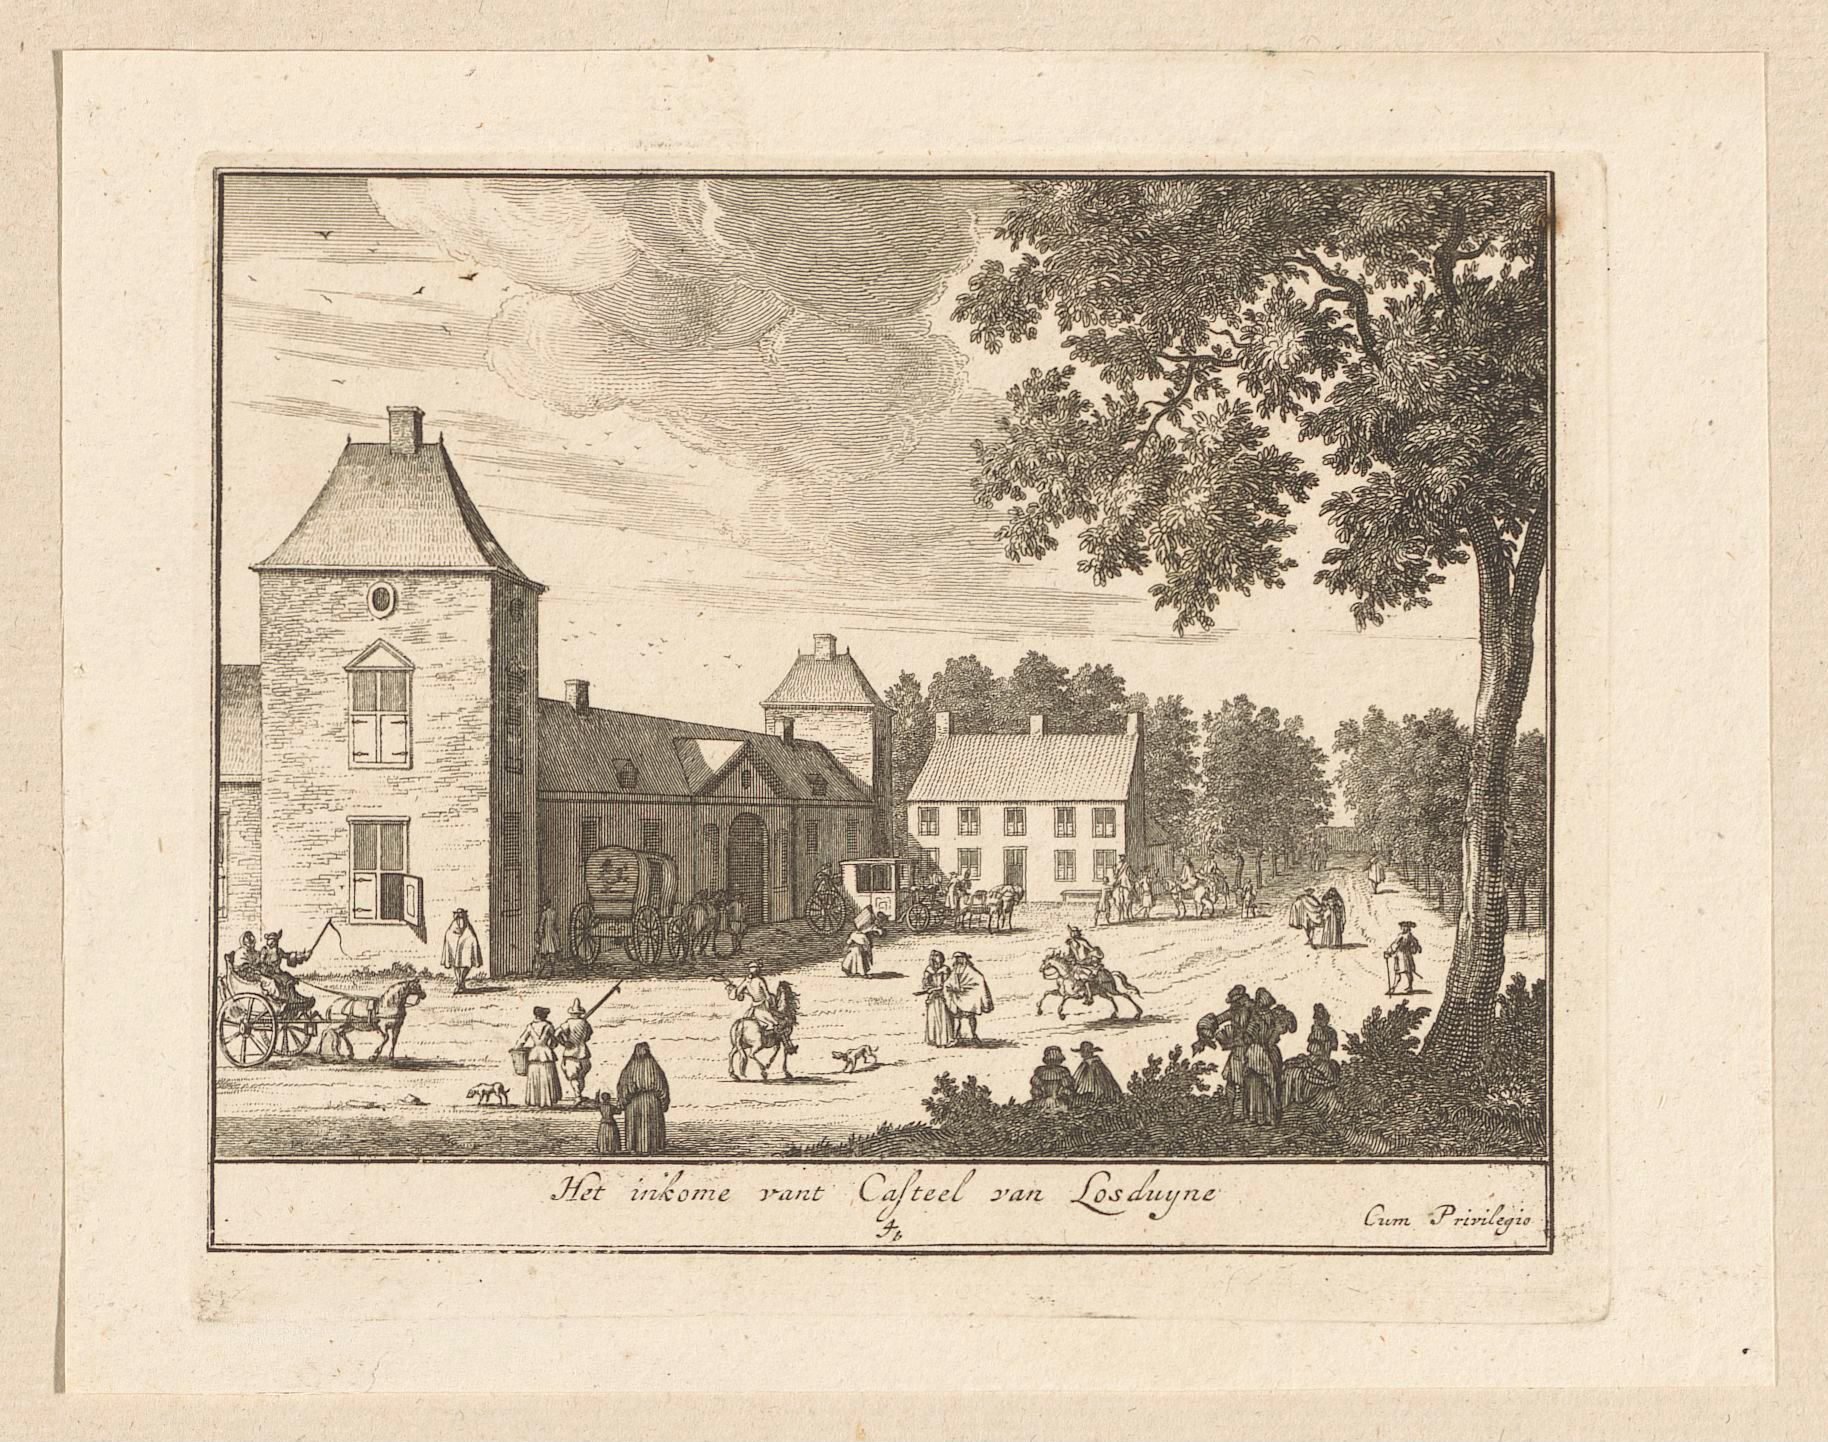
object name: print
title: Zestien prenten van Paleis Honselaarsdijk (Bloteling / Valck / Greve)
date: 1695-1757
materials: paper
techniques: engraving, etching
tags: road, path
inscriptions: collector's mark: Lugt 2233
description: Onderdeel van een serie van zestien prenten van Paleis Honselaarsdijk, oorspronkelijk gemaakt (en waarschijnlijk ook uitgegeven) door Abraham Bloteling rond 1684. Op de eerste staat van de prenten stond zijn naam linksonder, de sporen hiervan zijn met name op de negende prent (RP-P-AO-11-80-9B) nog duidelijk te zien. Deze staat van de serie is zeldzaam, mogelijk bezit de Bibliothèque Nationale een exemplaar. Zijn schoonbroer Gerard Valck heeft de reeks vervolgens in 1695 uitgegeven samen met drie andere prentseries onder de titel 'Veues et perspectives de Loo, Honslardyck et Soesdyck, chasteaux & maisons de plaisance du Roy de la Grande Bretagne, ausquels on a adjoûté les veuës des environs de Cleves', met voor de prenten van Honselaarsdijk de subtitel 'Veues et perspectives de Honslardyck, chasteau et maison de plaisance du Roy de la Grande Bretagne, le tout dessiné & gravé par les plus habiles maistres'. Valck heeft de platen aangepast waardoor van elke prent een tweede staat ontstond. Vervolgens zijn de platen in handen van Isaac Greve gekomen, die de serie nog een keer uitgaf onder de titel '16. gesigte van 't koninglyke lust huys Honslardyk'. Vermoedelijk heeft Greve alleen de plaat van de eerste prent bijgewerkt en de rest onveranderd gelaten waardoor van de eerste prent drie staten bekend zijn en van de rest twee.